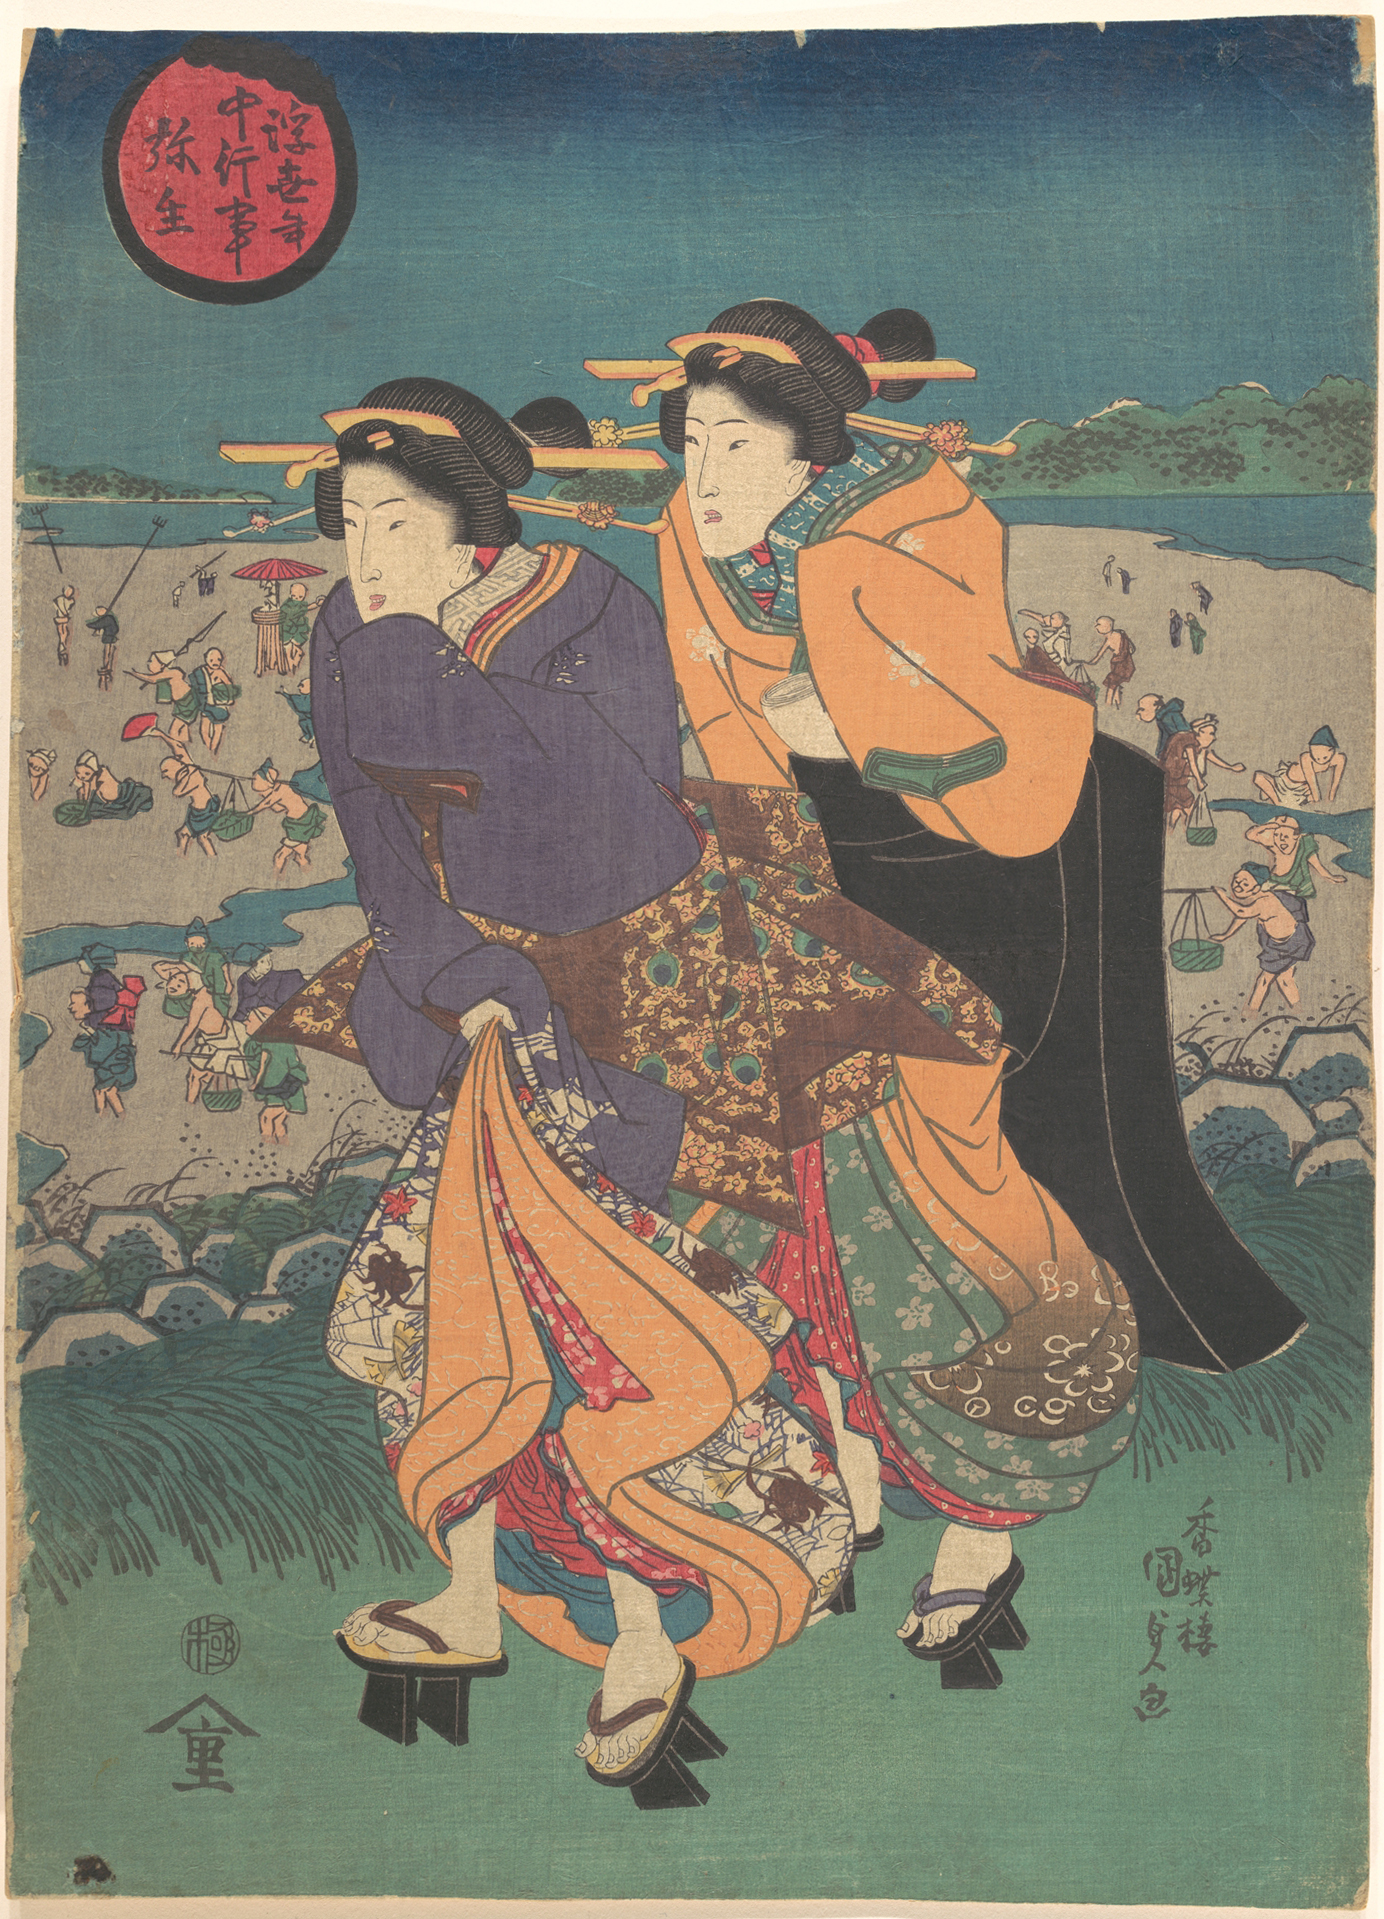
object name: print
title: Annual event - the third month (Ukiyo nenjū gyōji: Yayoi)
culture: japanese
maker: utagawa kunisada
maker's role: artist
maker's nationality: japanese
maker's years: 1786-1864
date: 1834-1866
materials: ink, paper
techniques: woodblock print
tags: women